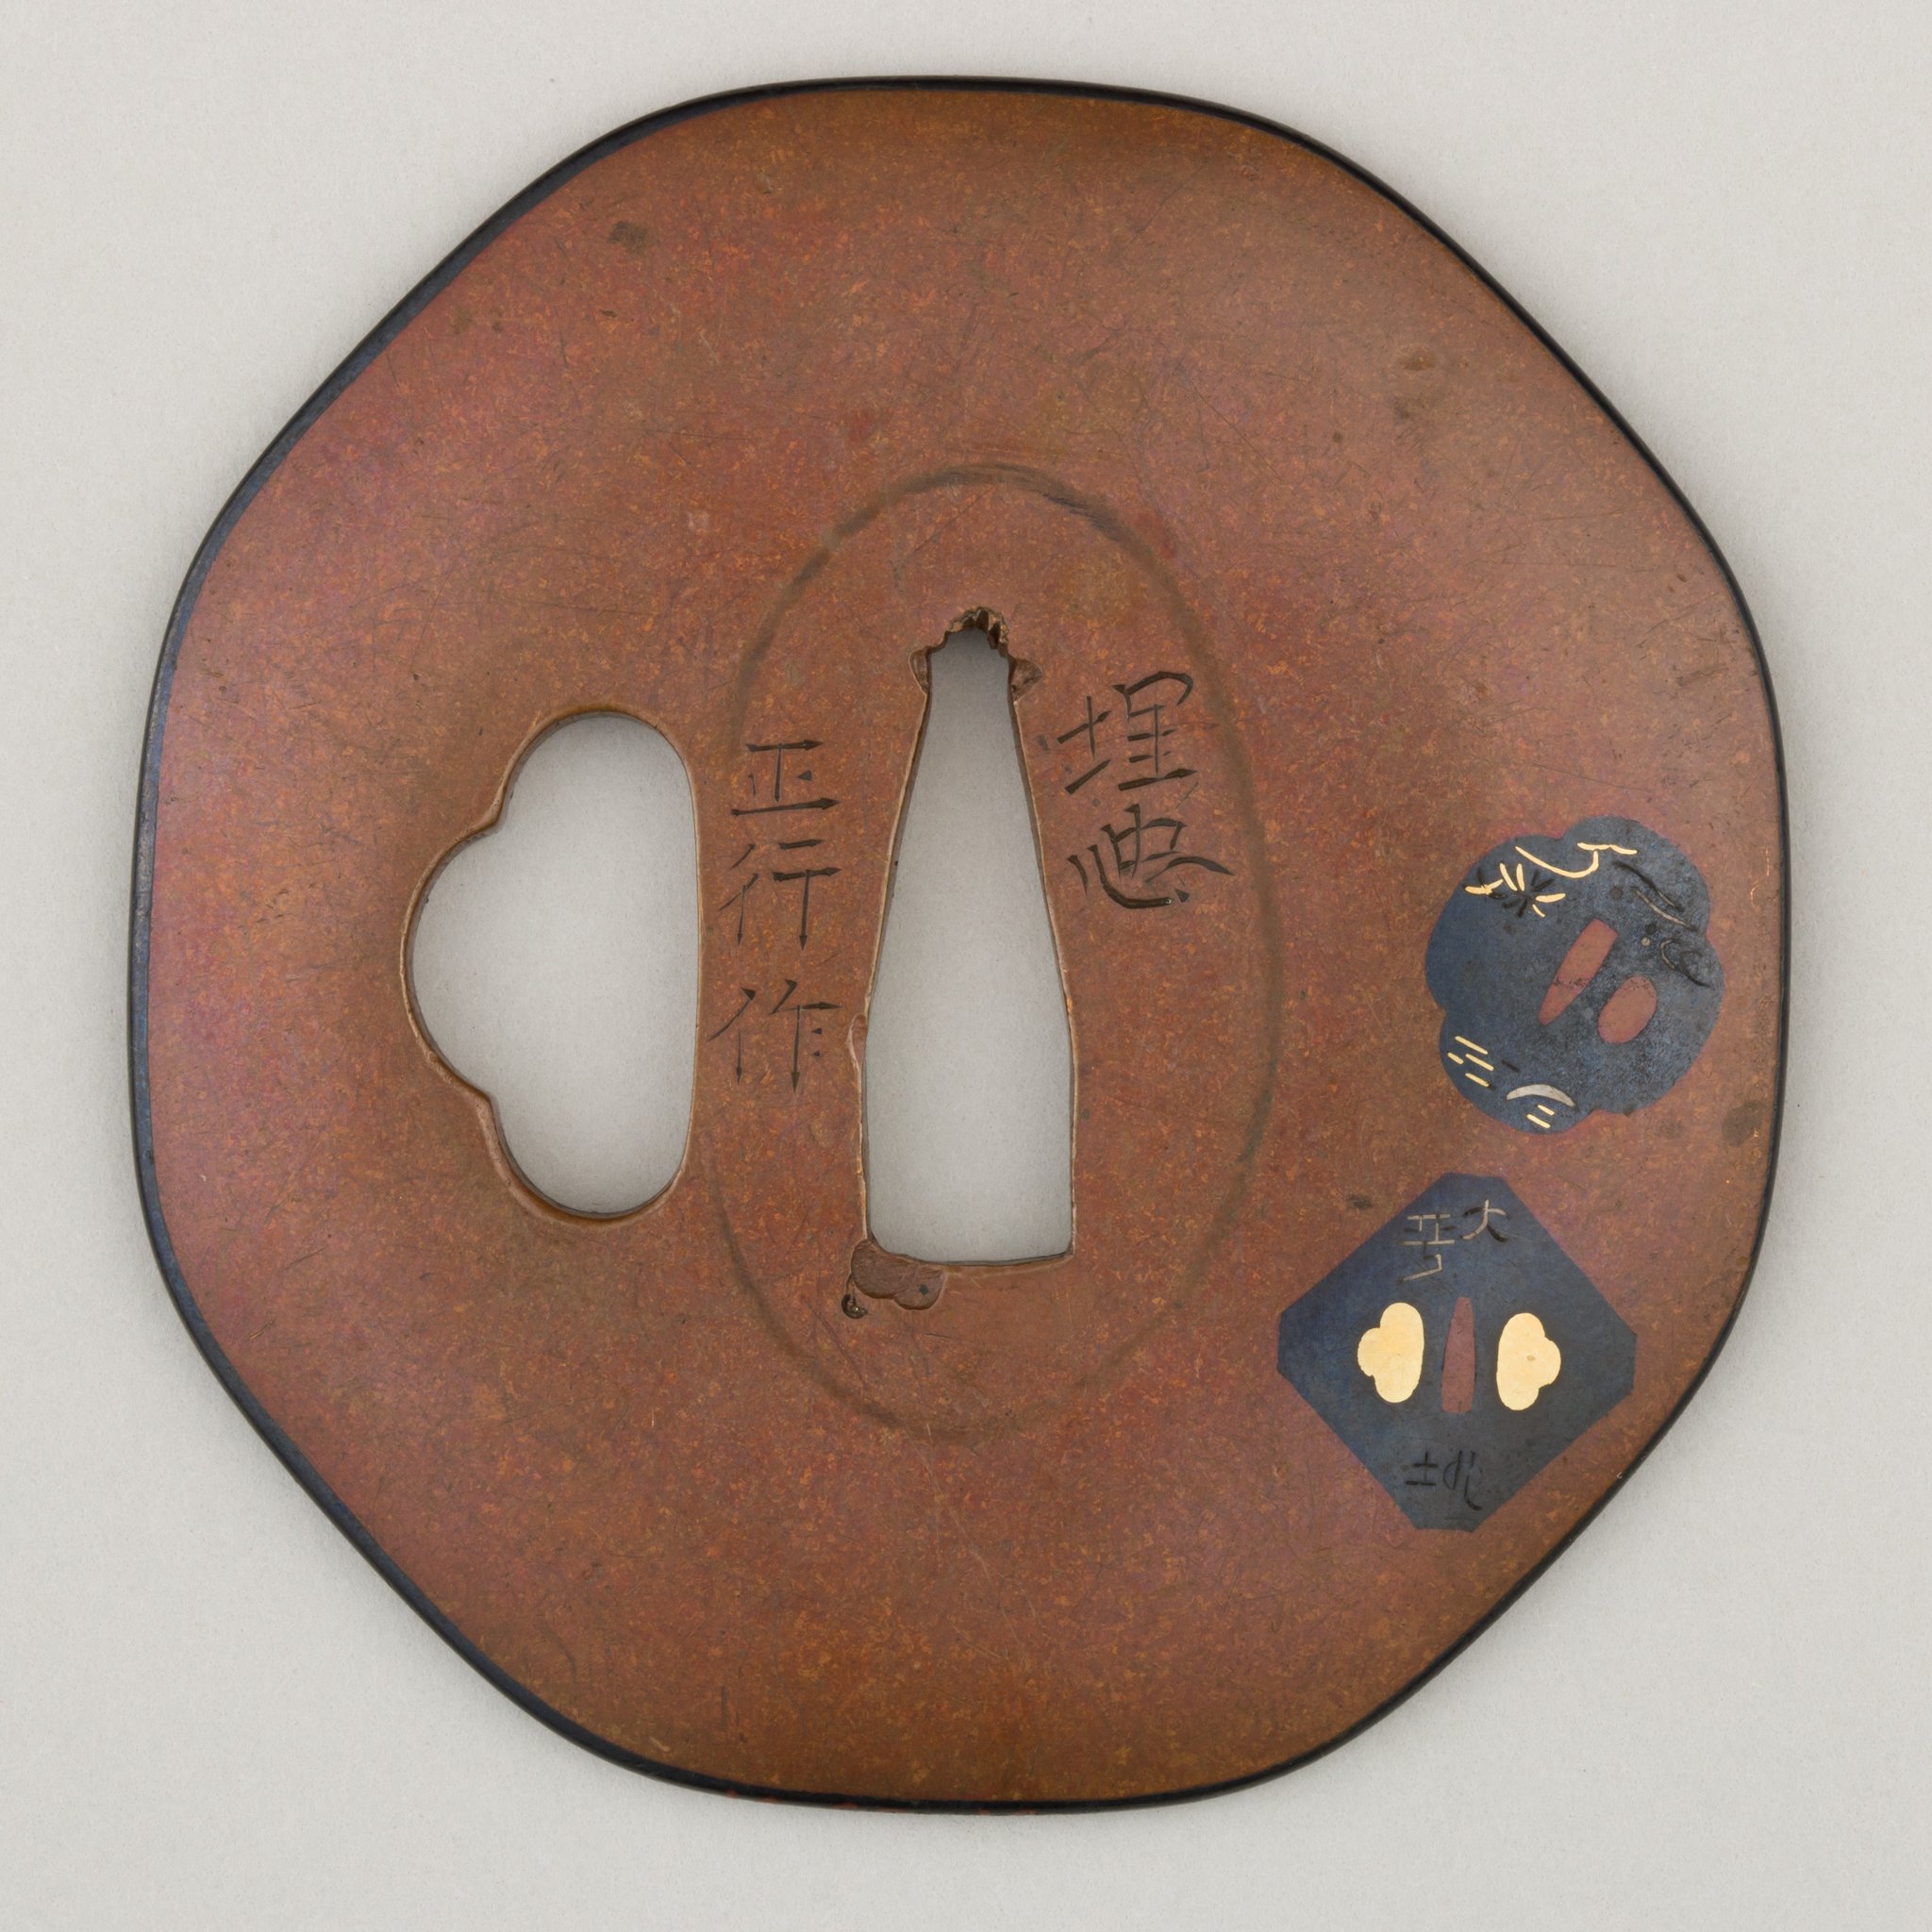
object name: sword guard tsuba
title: Sword Guard (Tsuba)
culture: japanese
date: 1801-1900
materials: copper, copper alloy, gold alloy, gold, silver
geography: japan